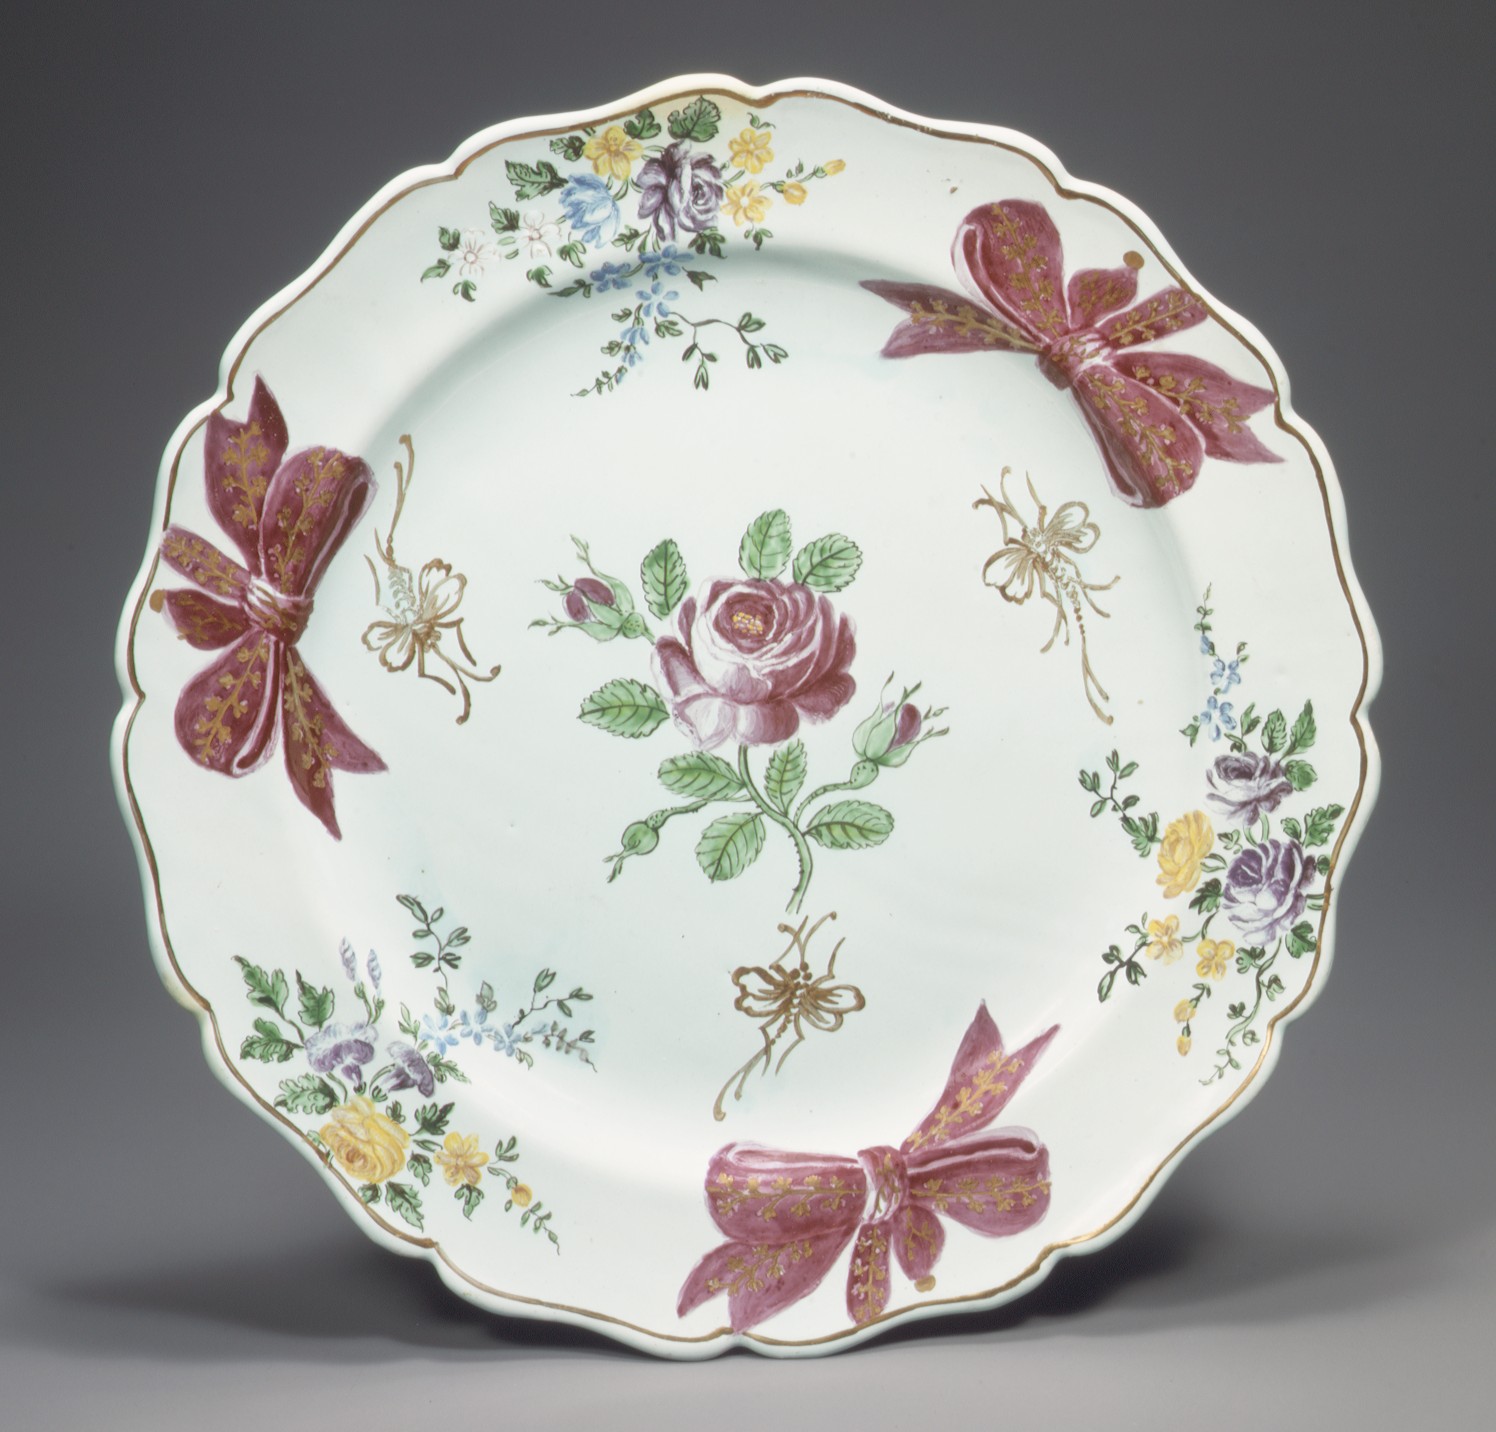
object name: plate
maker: veuve perrin factory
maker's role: factory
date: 1763-1765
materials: faience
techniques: glazing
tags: insects,flowers